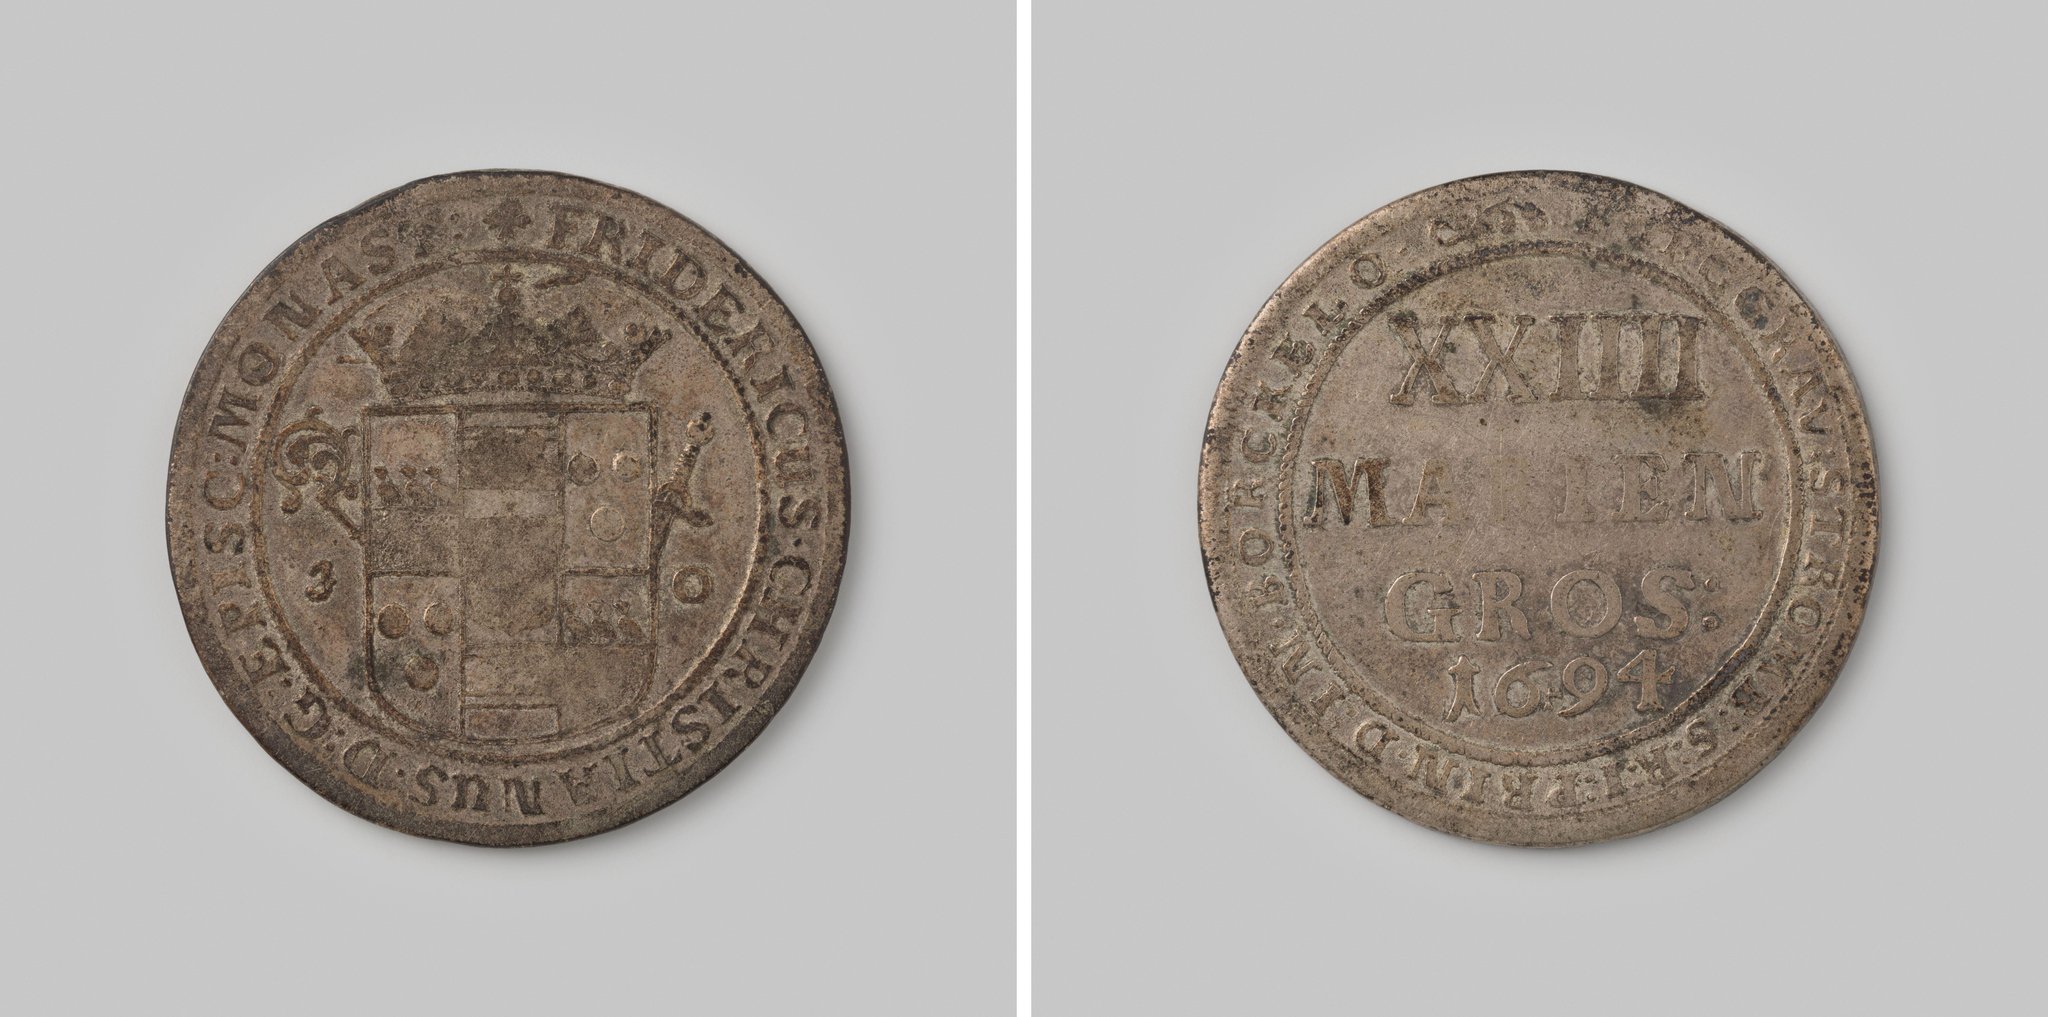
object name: coin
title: Bisdom Münster, Friedrich Christian von Plettenberg, 24 Mariengroschen, 1694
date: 1694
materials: silver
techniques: striking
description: Zilveren munt. Voorzijde: op een bisschopsstaf en een zwaard versierd samengesteld wapenschild, waarop kroon. Keerzijde: waarde-aanduiding in drie regels, waaronder jaartal. Gladde rand.